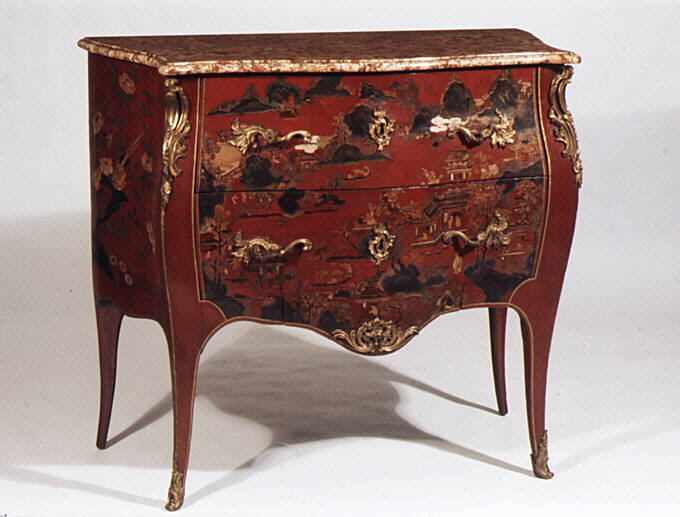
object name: commode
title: Small commode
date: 1765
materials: gilt bronze, lacquer, marble, wood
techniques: painting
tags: landscapes